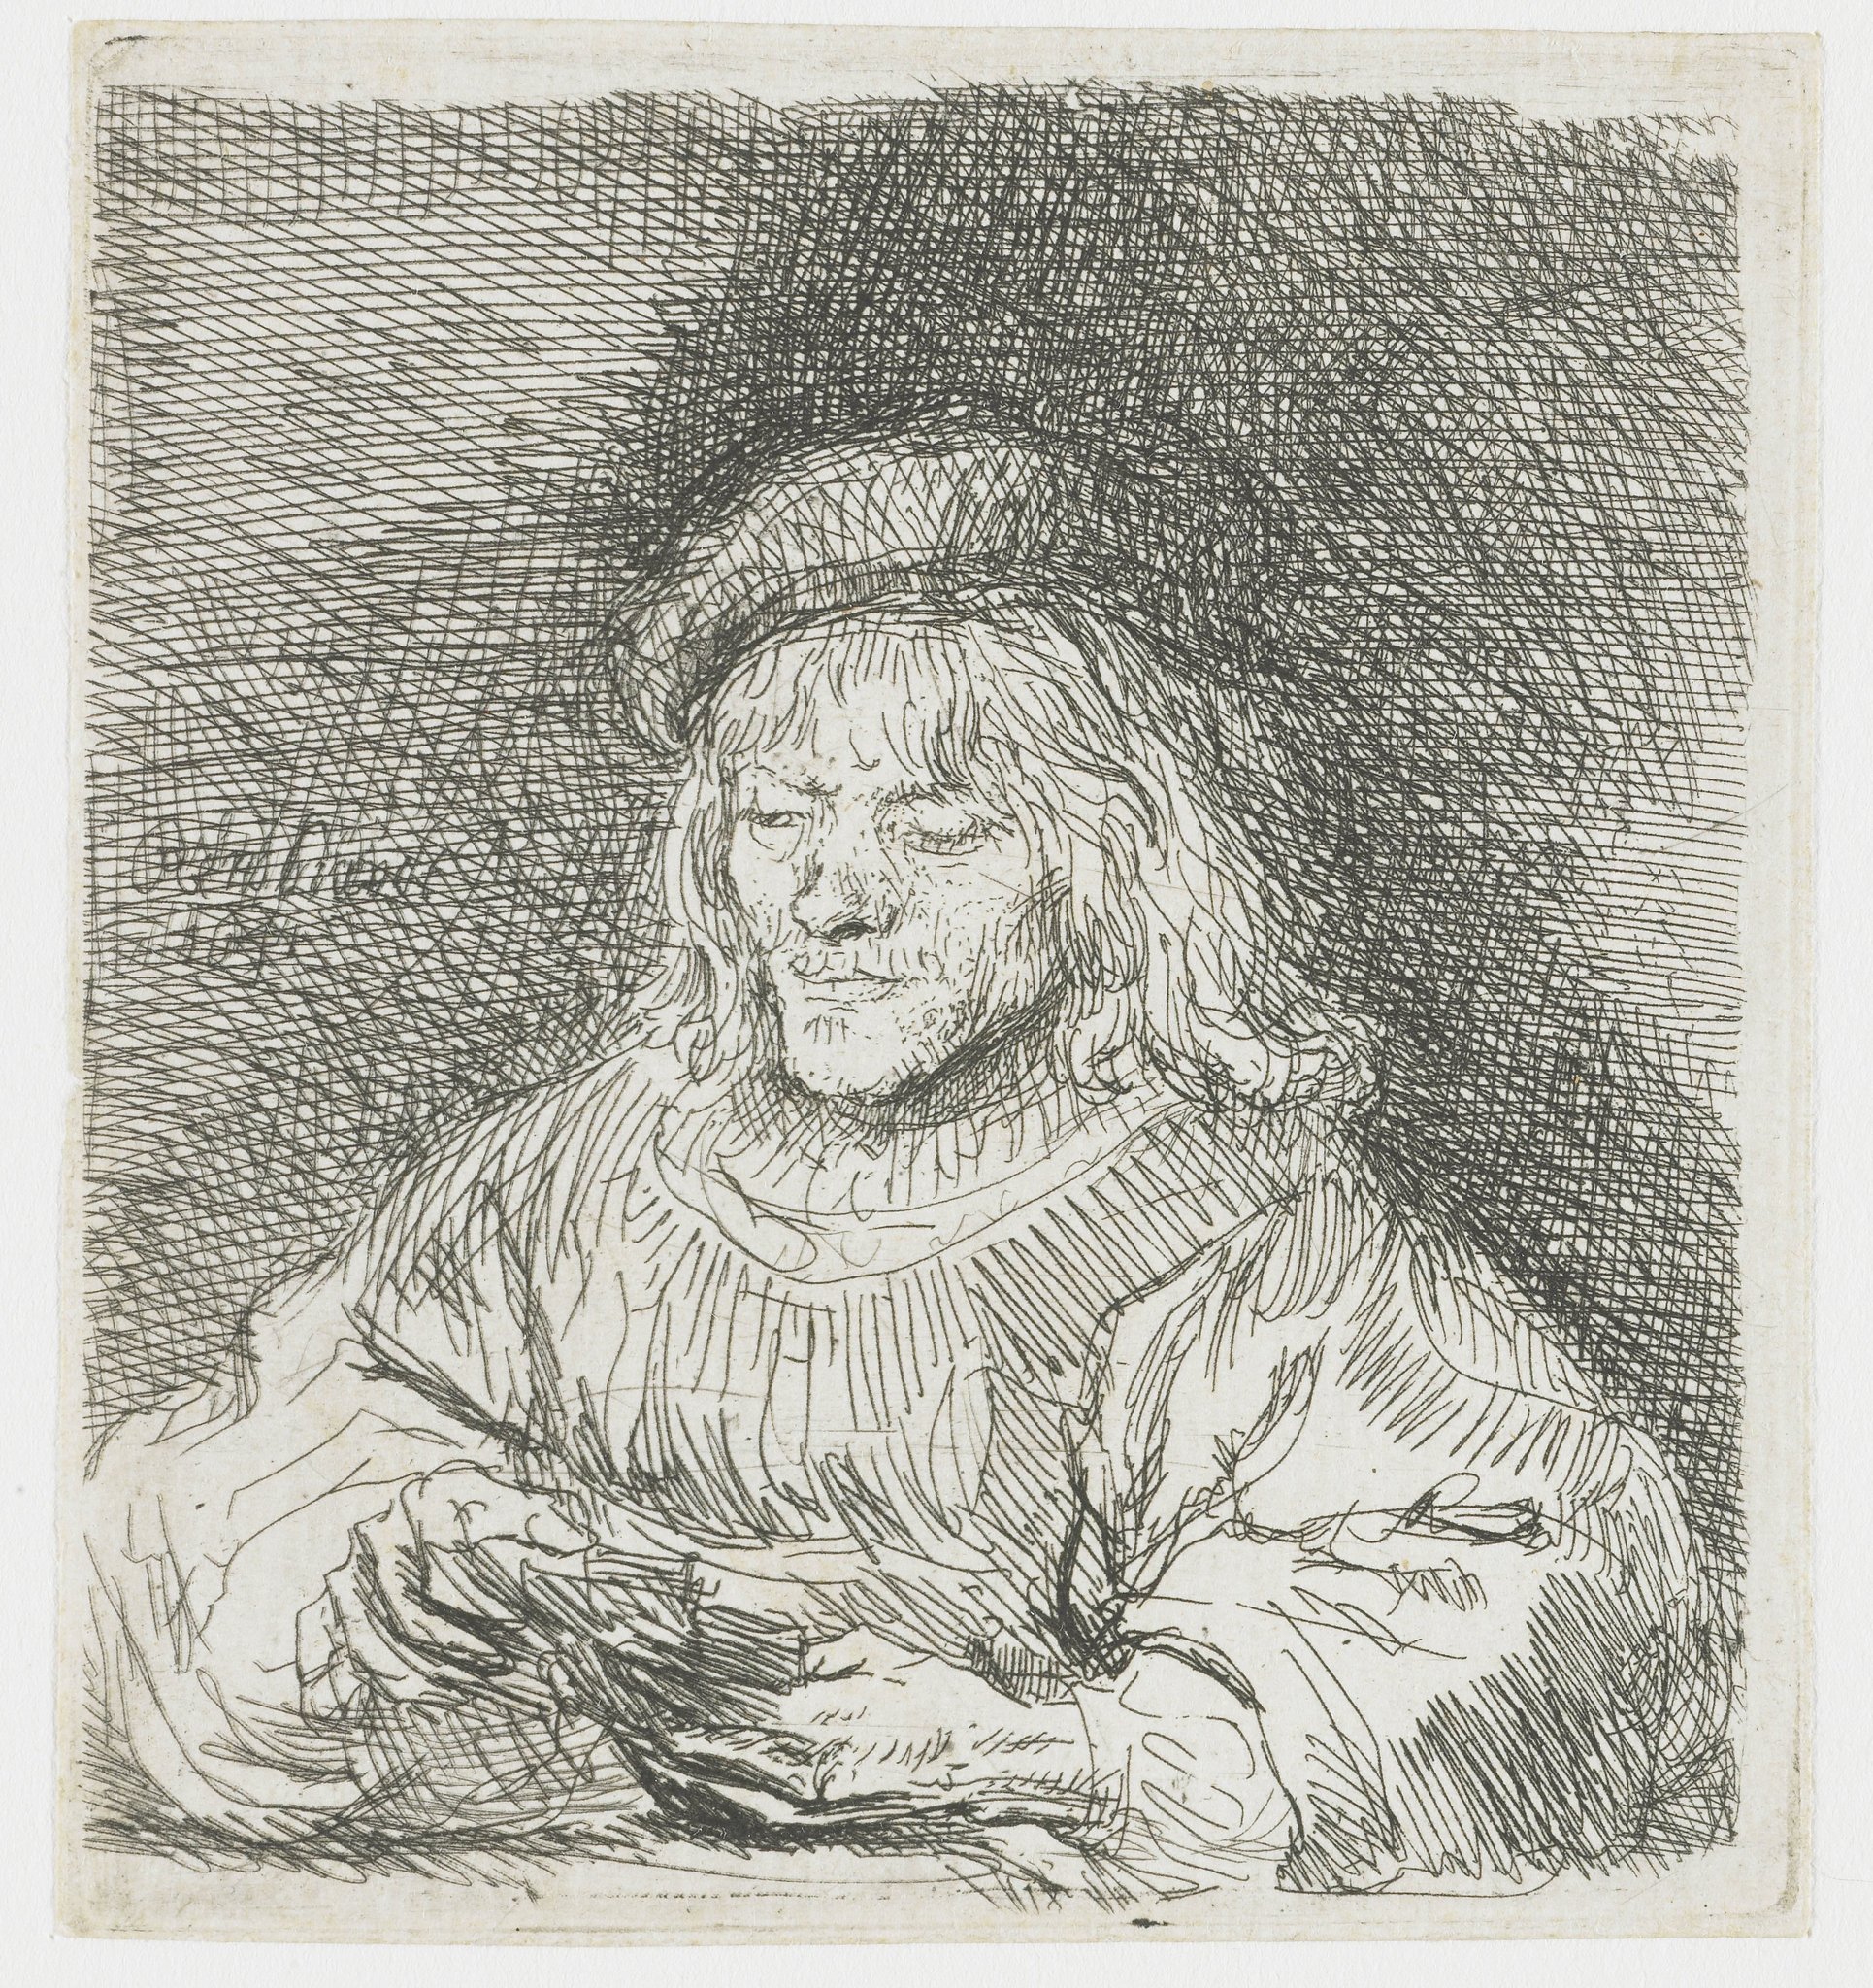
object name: print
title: The card player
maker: rembrandt van rijn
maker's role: draughtsman, painter, print maker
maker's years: 1606-1669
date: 1641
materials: paper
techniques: etching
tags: card games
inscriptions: signature and date: ‘Rembrandt f 1641’, mark: Lugt 2228, mark: Lugt 2009